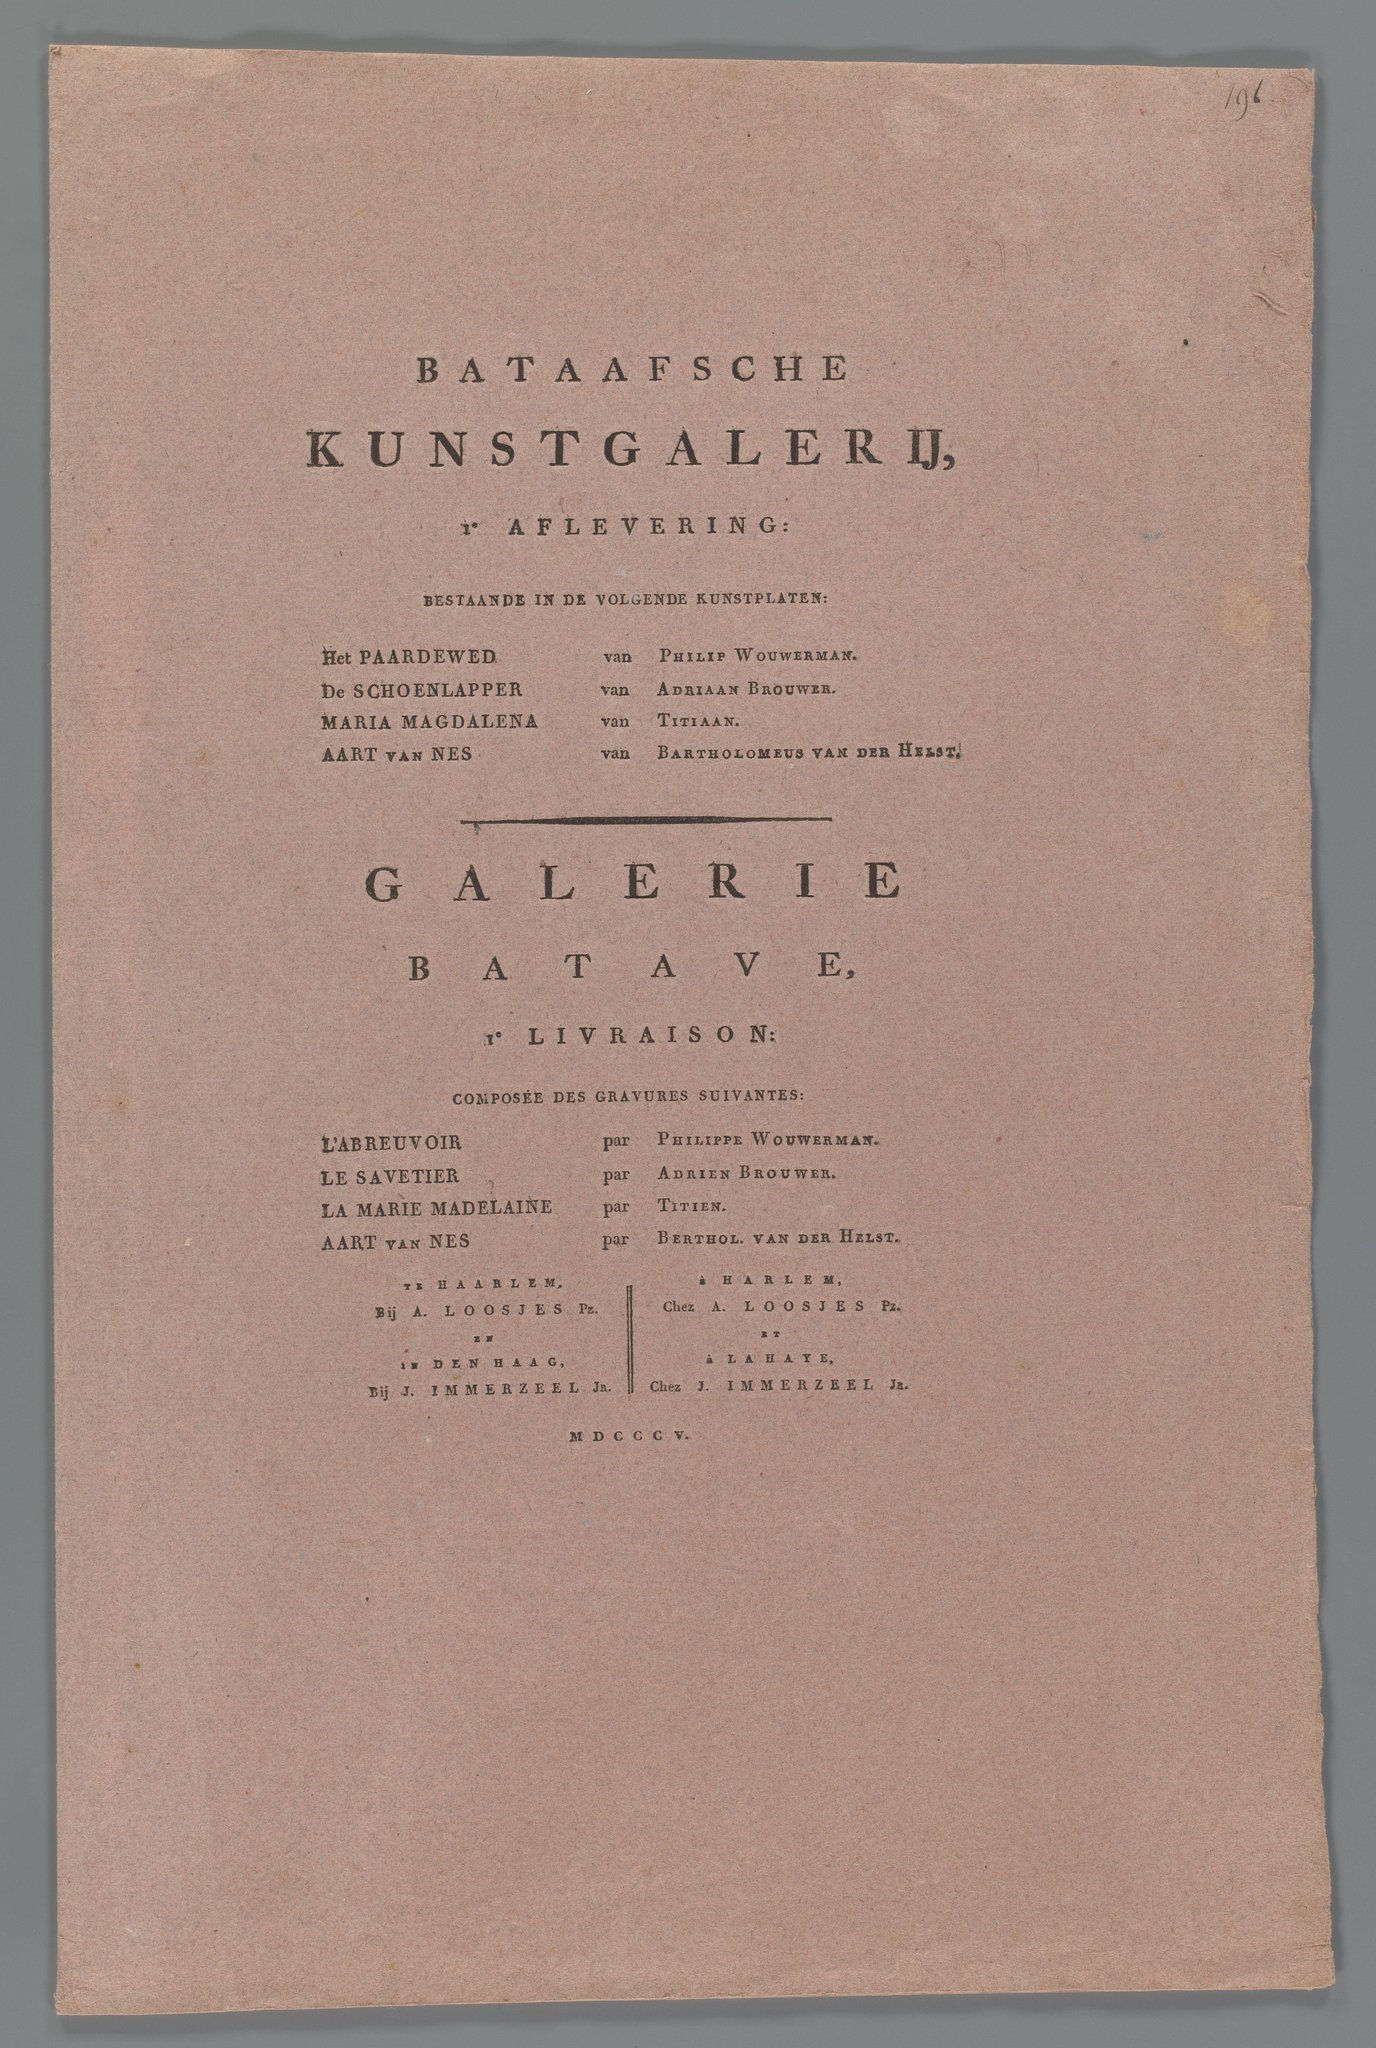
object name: wrapper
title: Omslag voor drie tekstbladen met opdracht aan Rutger Jan Schimmelpenninck en toelichting bij vier prenten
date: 1805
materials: paper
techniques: letterpress printing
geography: haarlem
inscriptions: number: ‘196’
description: Op het verso van de omslag een bericht aan het publiek van de uitgevers en dank aan de tekenaars, prentmakers en de plaatdrukker A. Koning te Amsterdam.